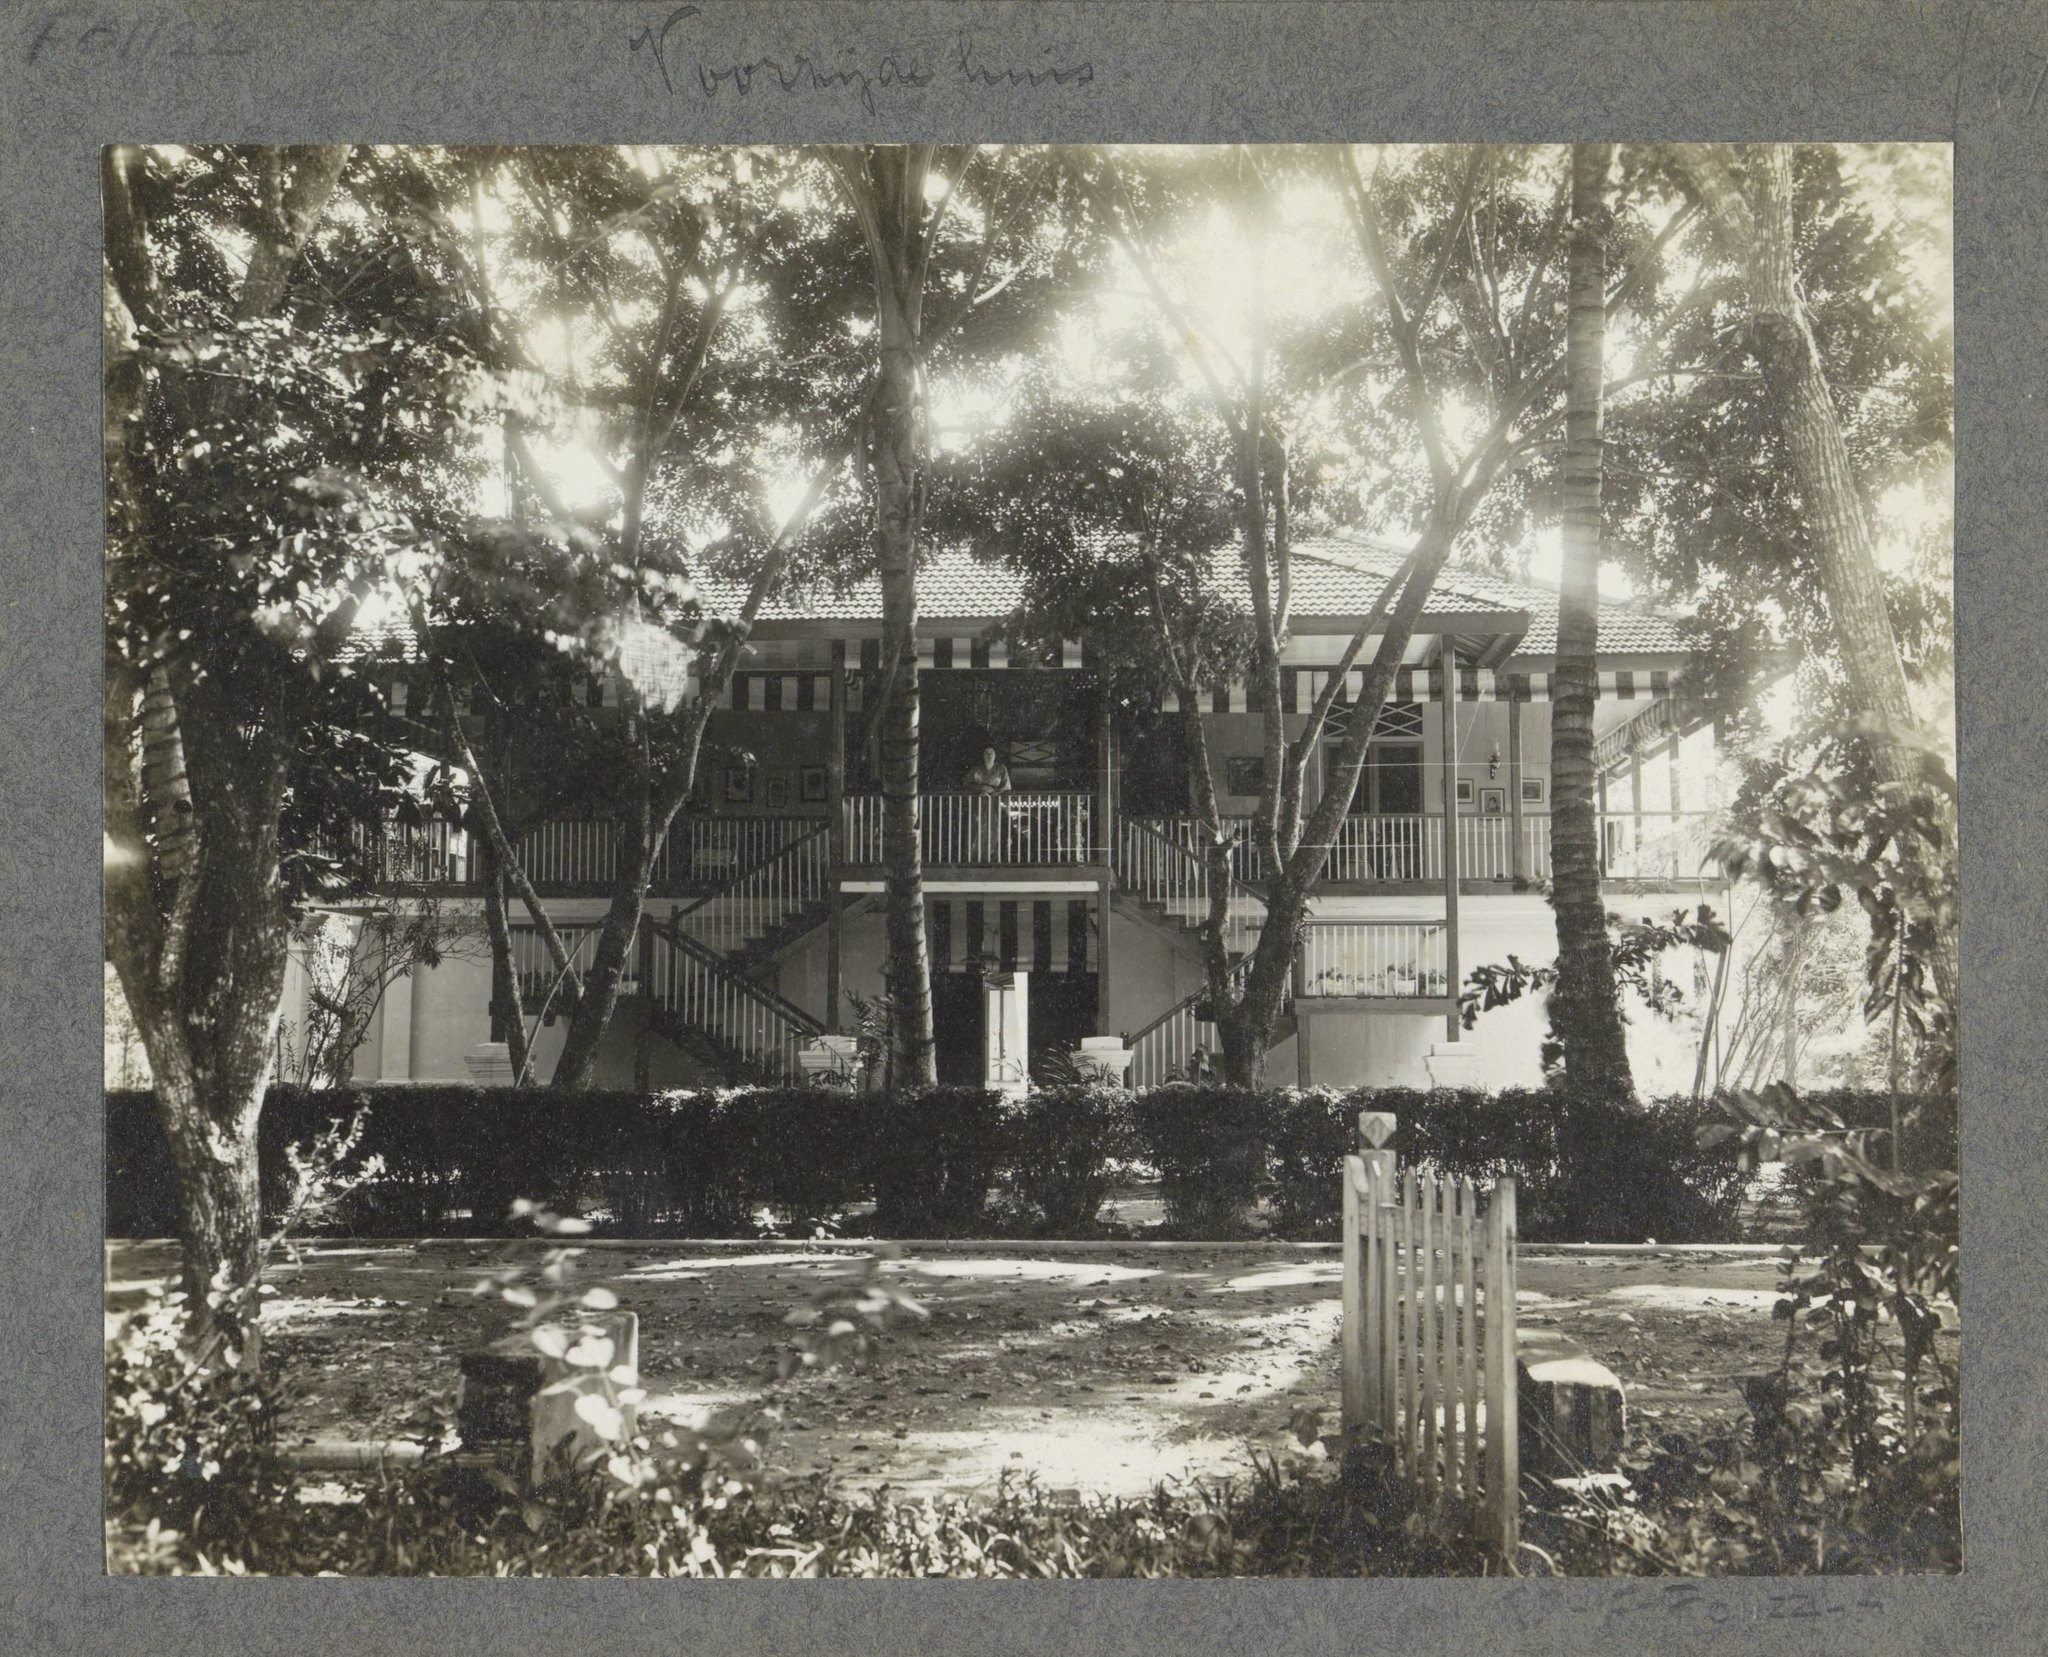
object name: photograph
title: Voorzijde van een woonhuis op Sumatra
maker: Anonymous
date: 1914-1926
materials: photographic support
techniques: gelatin silver print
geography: sumatra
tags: rural housing, e.g. country-house, villa, cottage, sumatra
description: Onderdeel van fotoalbum met opnames van de familie Bergsma in Tandjong Poera en Rantan Pandjang (Sumatra).